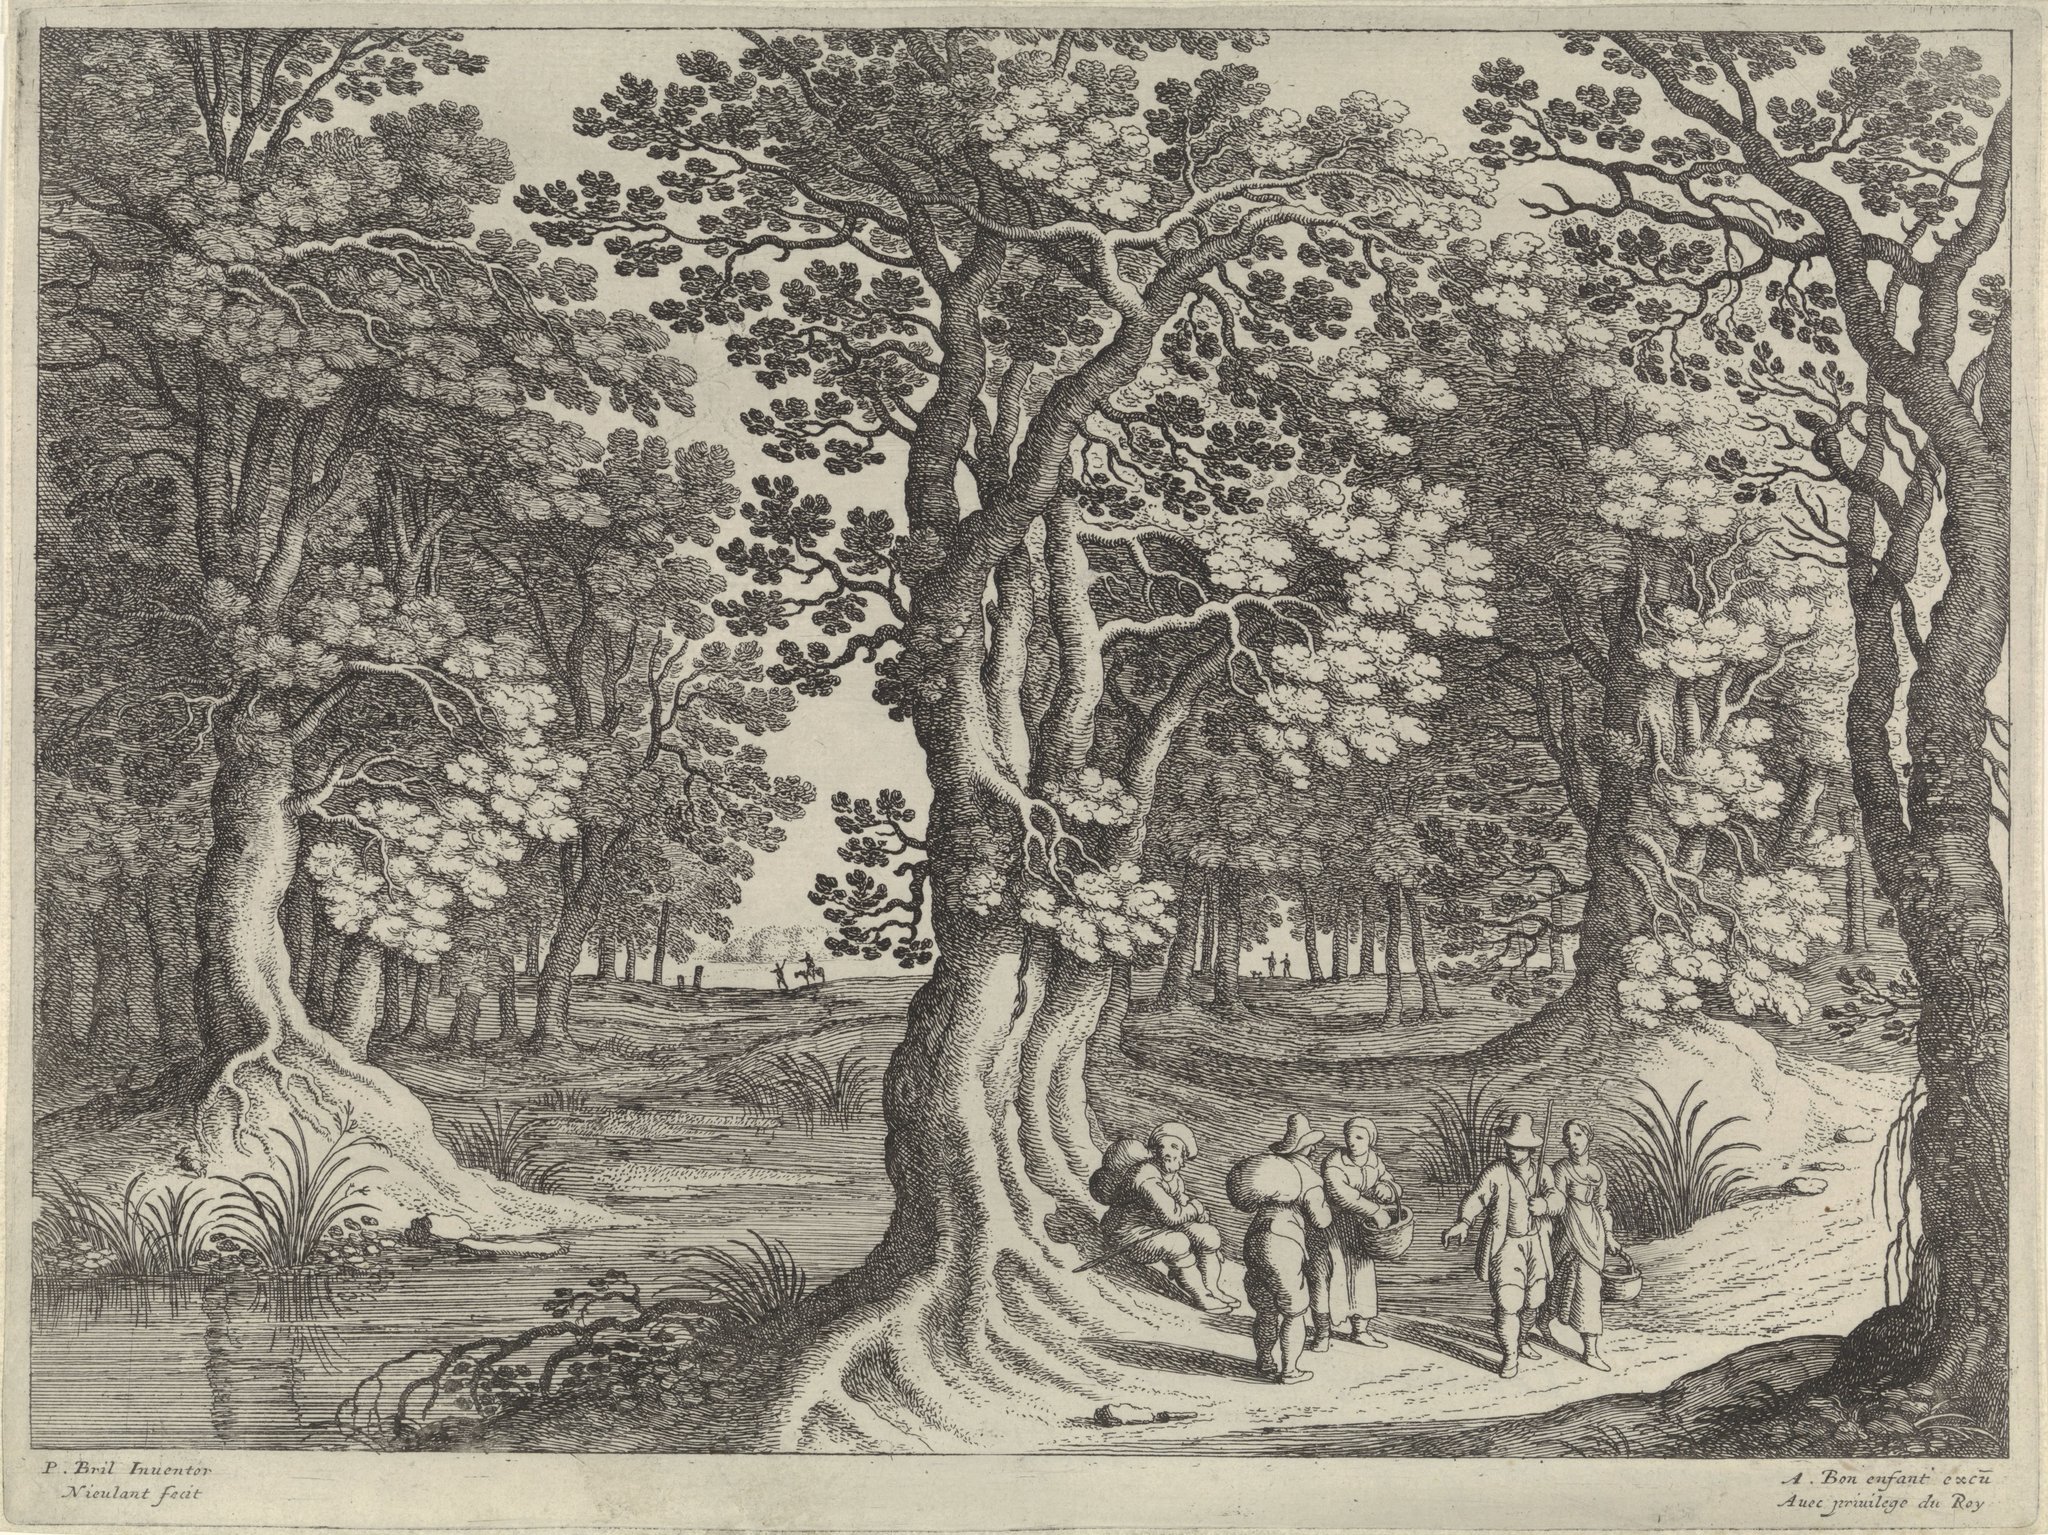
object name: print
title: Boslandschap met vijf reizigers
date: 1594-1635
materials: paper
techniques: engraving, etching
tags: forest path or lane, 'en route', traveller under way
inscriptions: collector's mark: Lugt 240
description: In een boslandschap, waar een riviertje doorheen stroomt, staan op de weg twee vrouwen en twee mannen. Naast hen zit een man onder een boom.